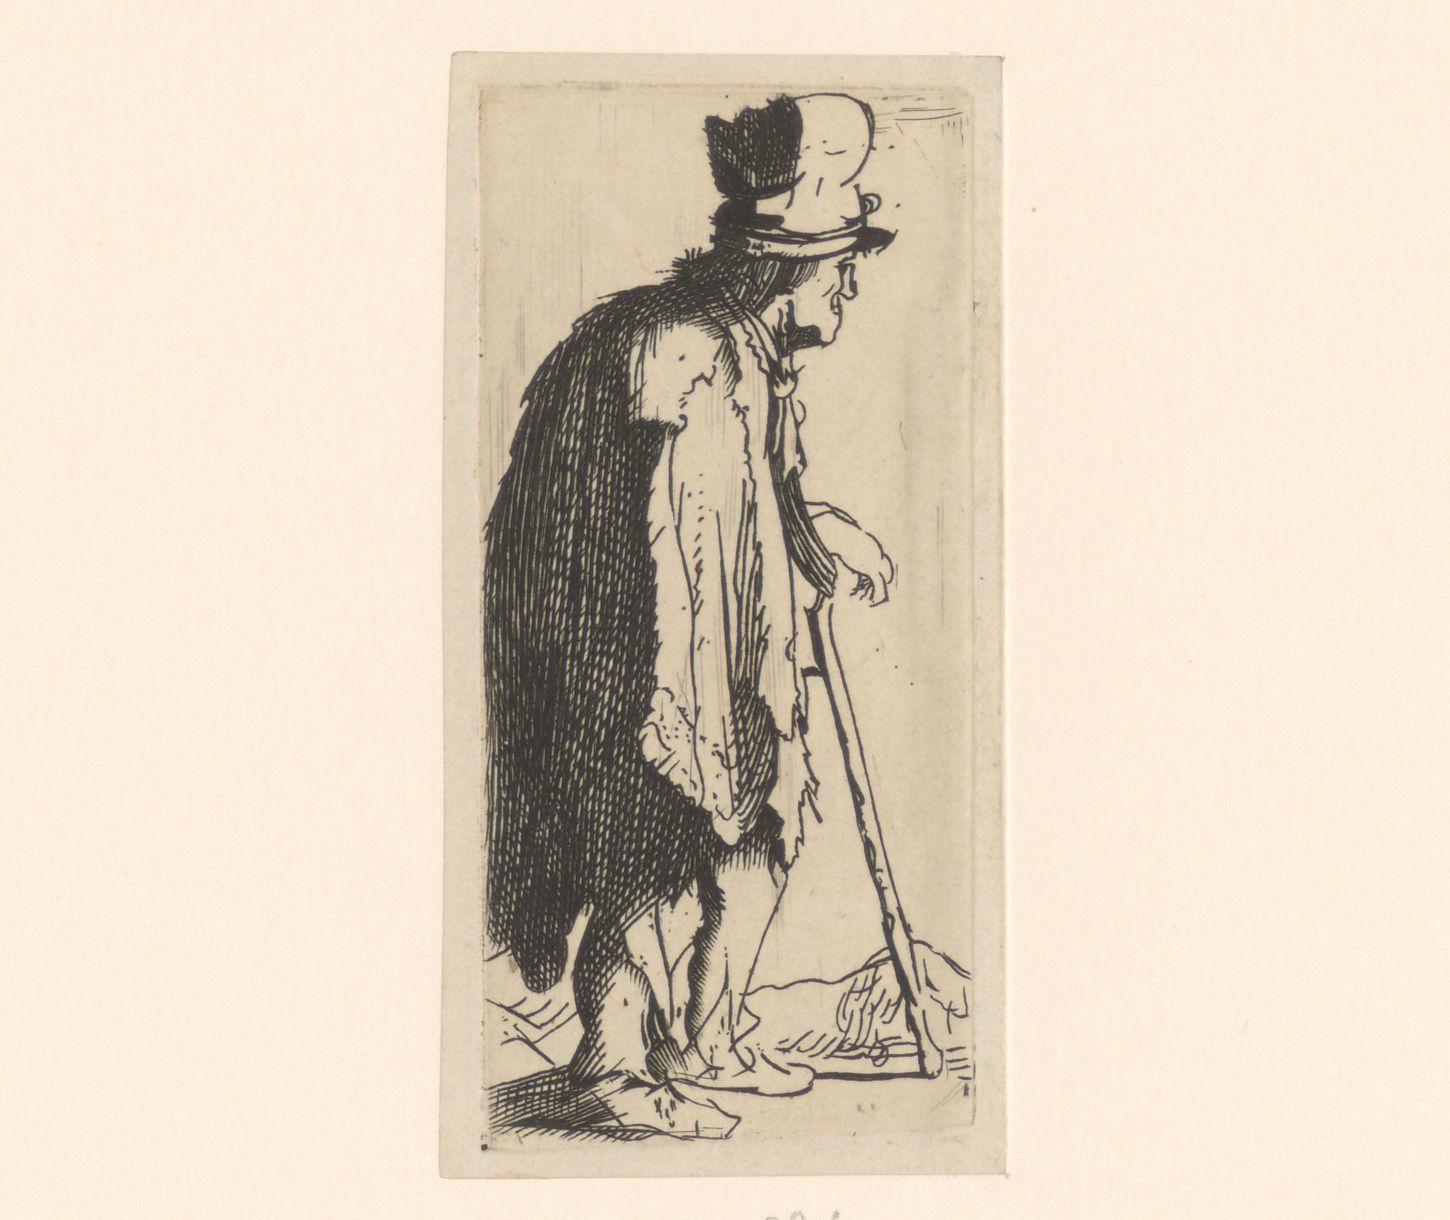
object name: print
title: Bedelaar met misvormde hand, leunend op een stok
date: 1824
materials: paper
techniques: etching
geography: london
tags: person with a physical disability, beggar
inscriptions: collector's mark: Lugt 2228